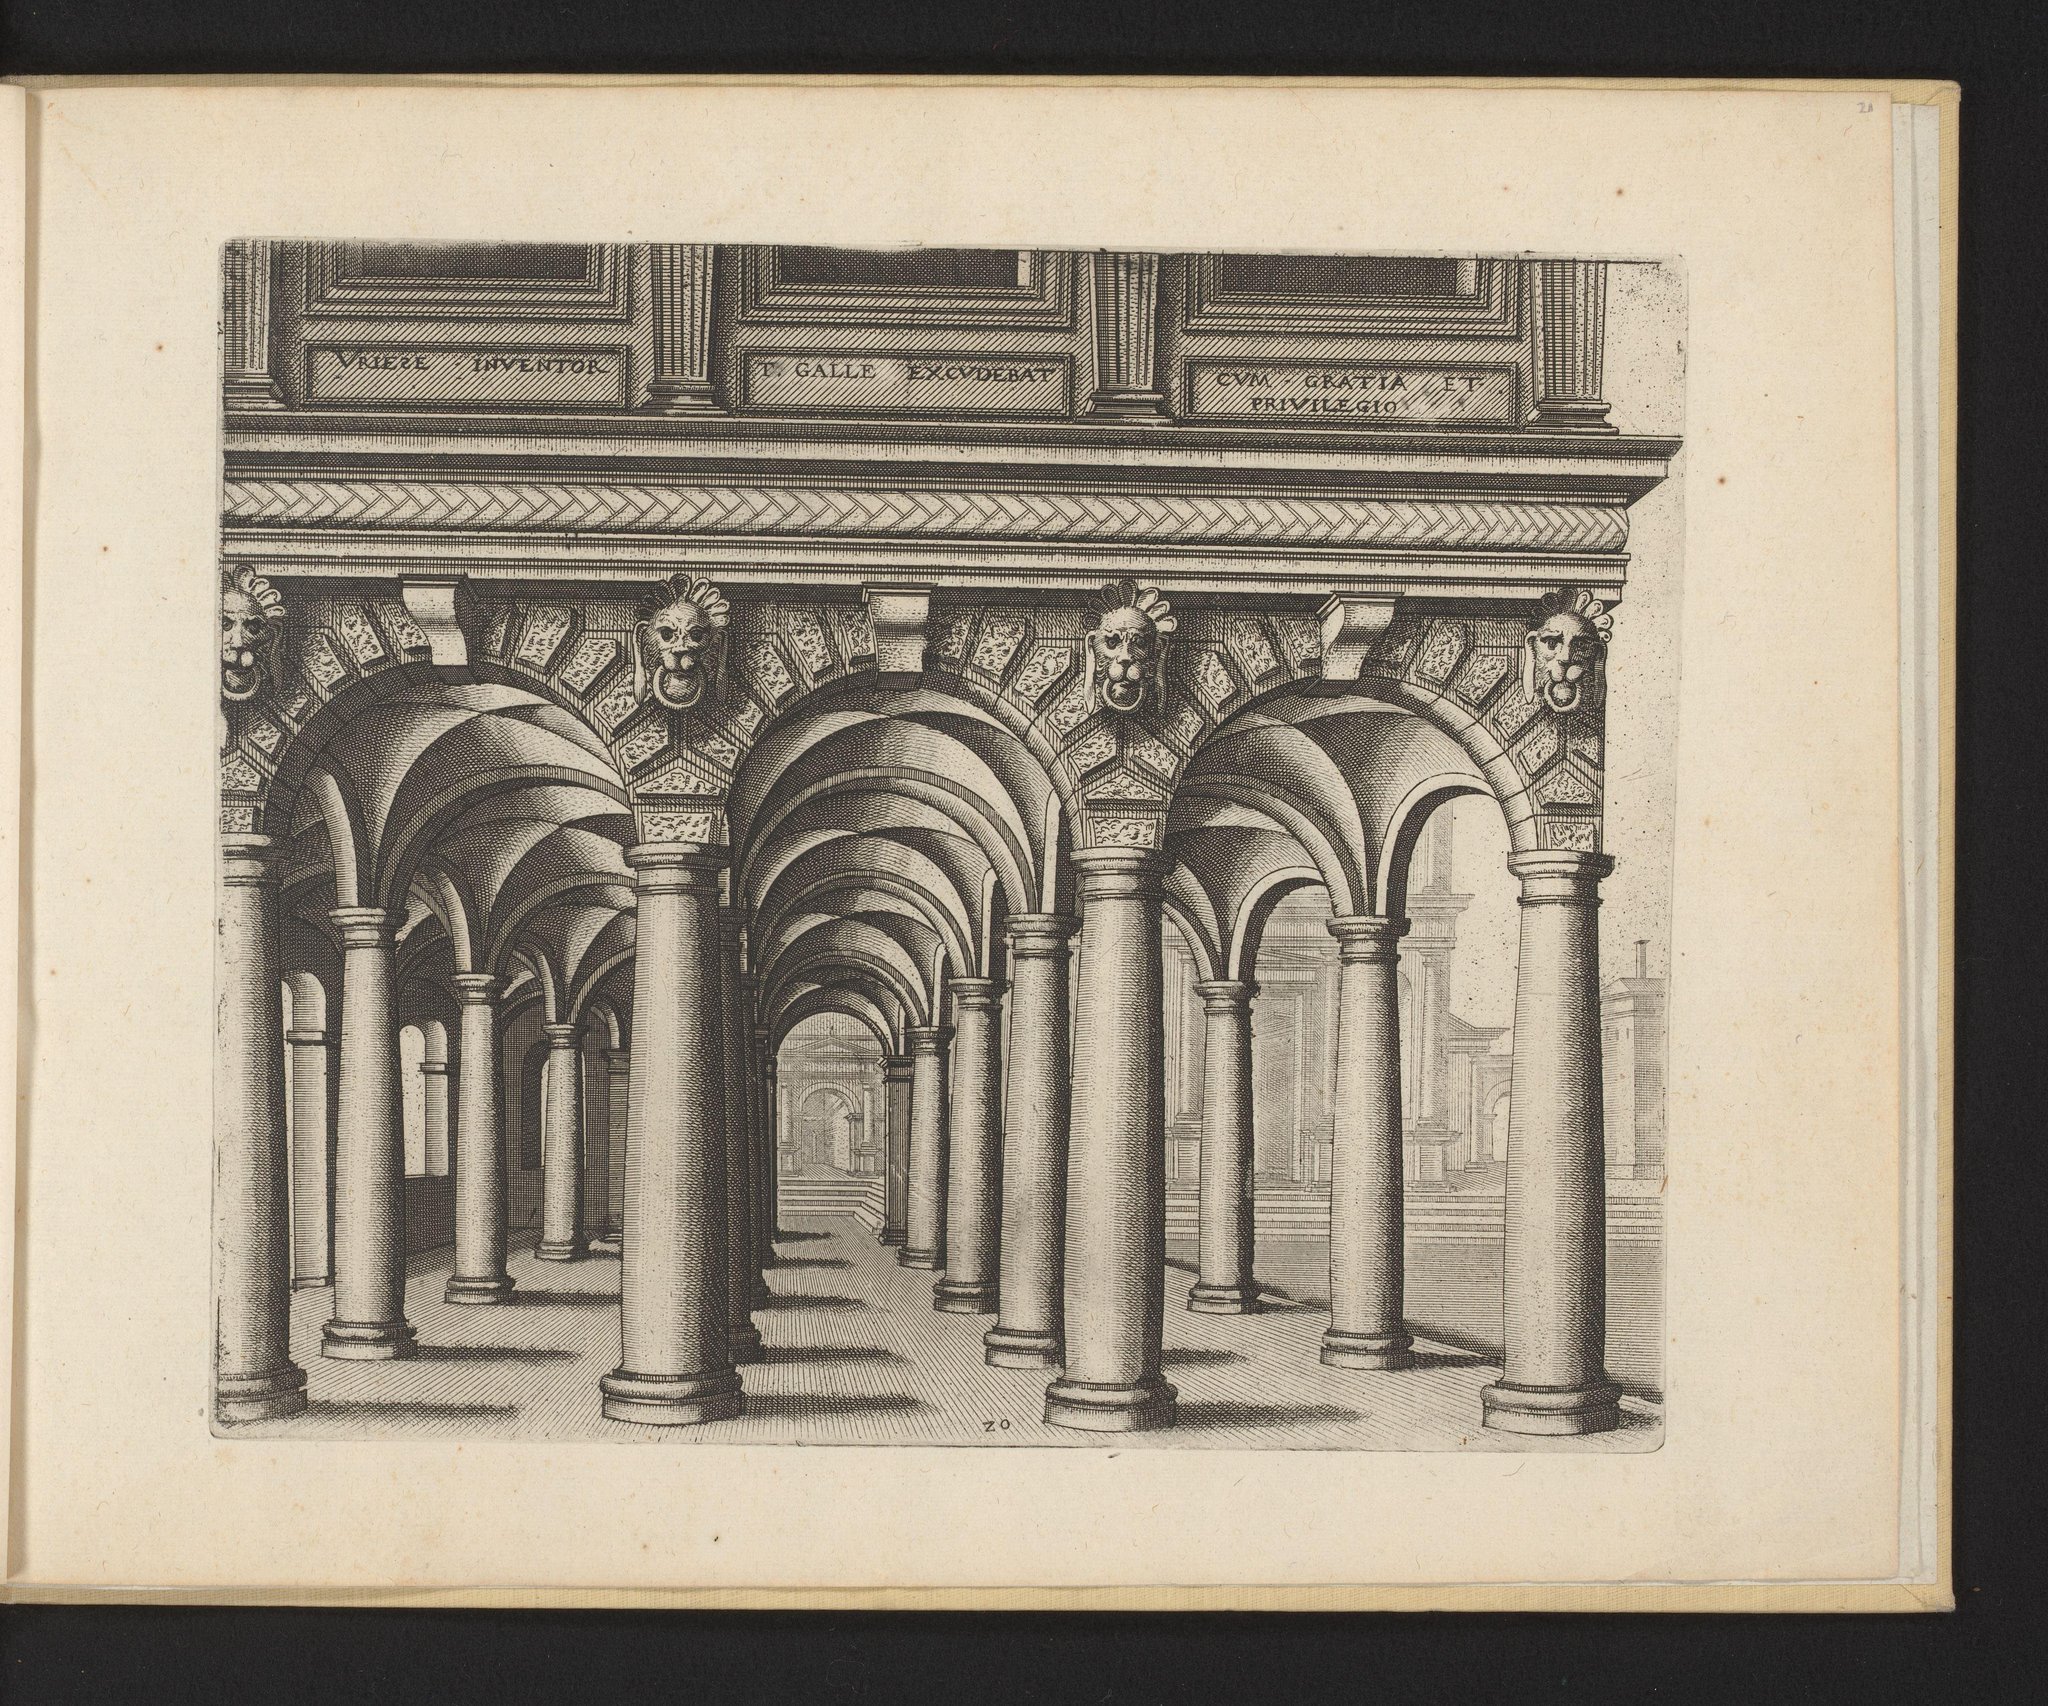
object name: album leaf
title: Variae architecturae formae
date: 1601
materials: paper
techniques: engraving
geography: antwerp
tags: column, pillar ~ architecture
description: Open hal met zuilen van de Toscaanse orde, gedecoreerd met rustica en mascarons. Rechts een stadsplein. De prent maakt deel uit van een album.